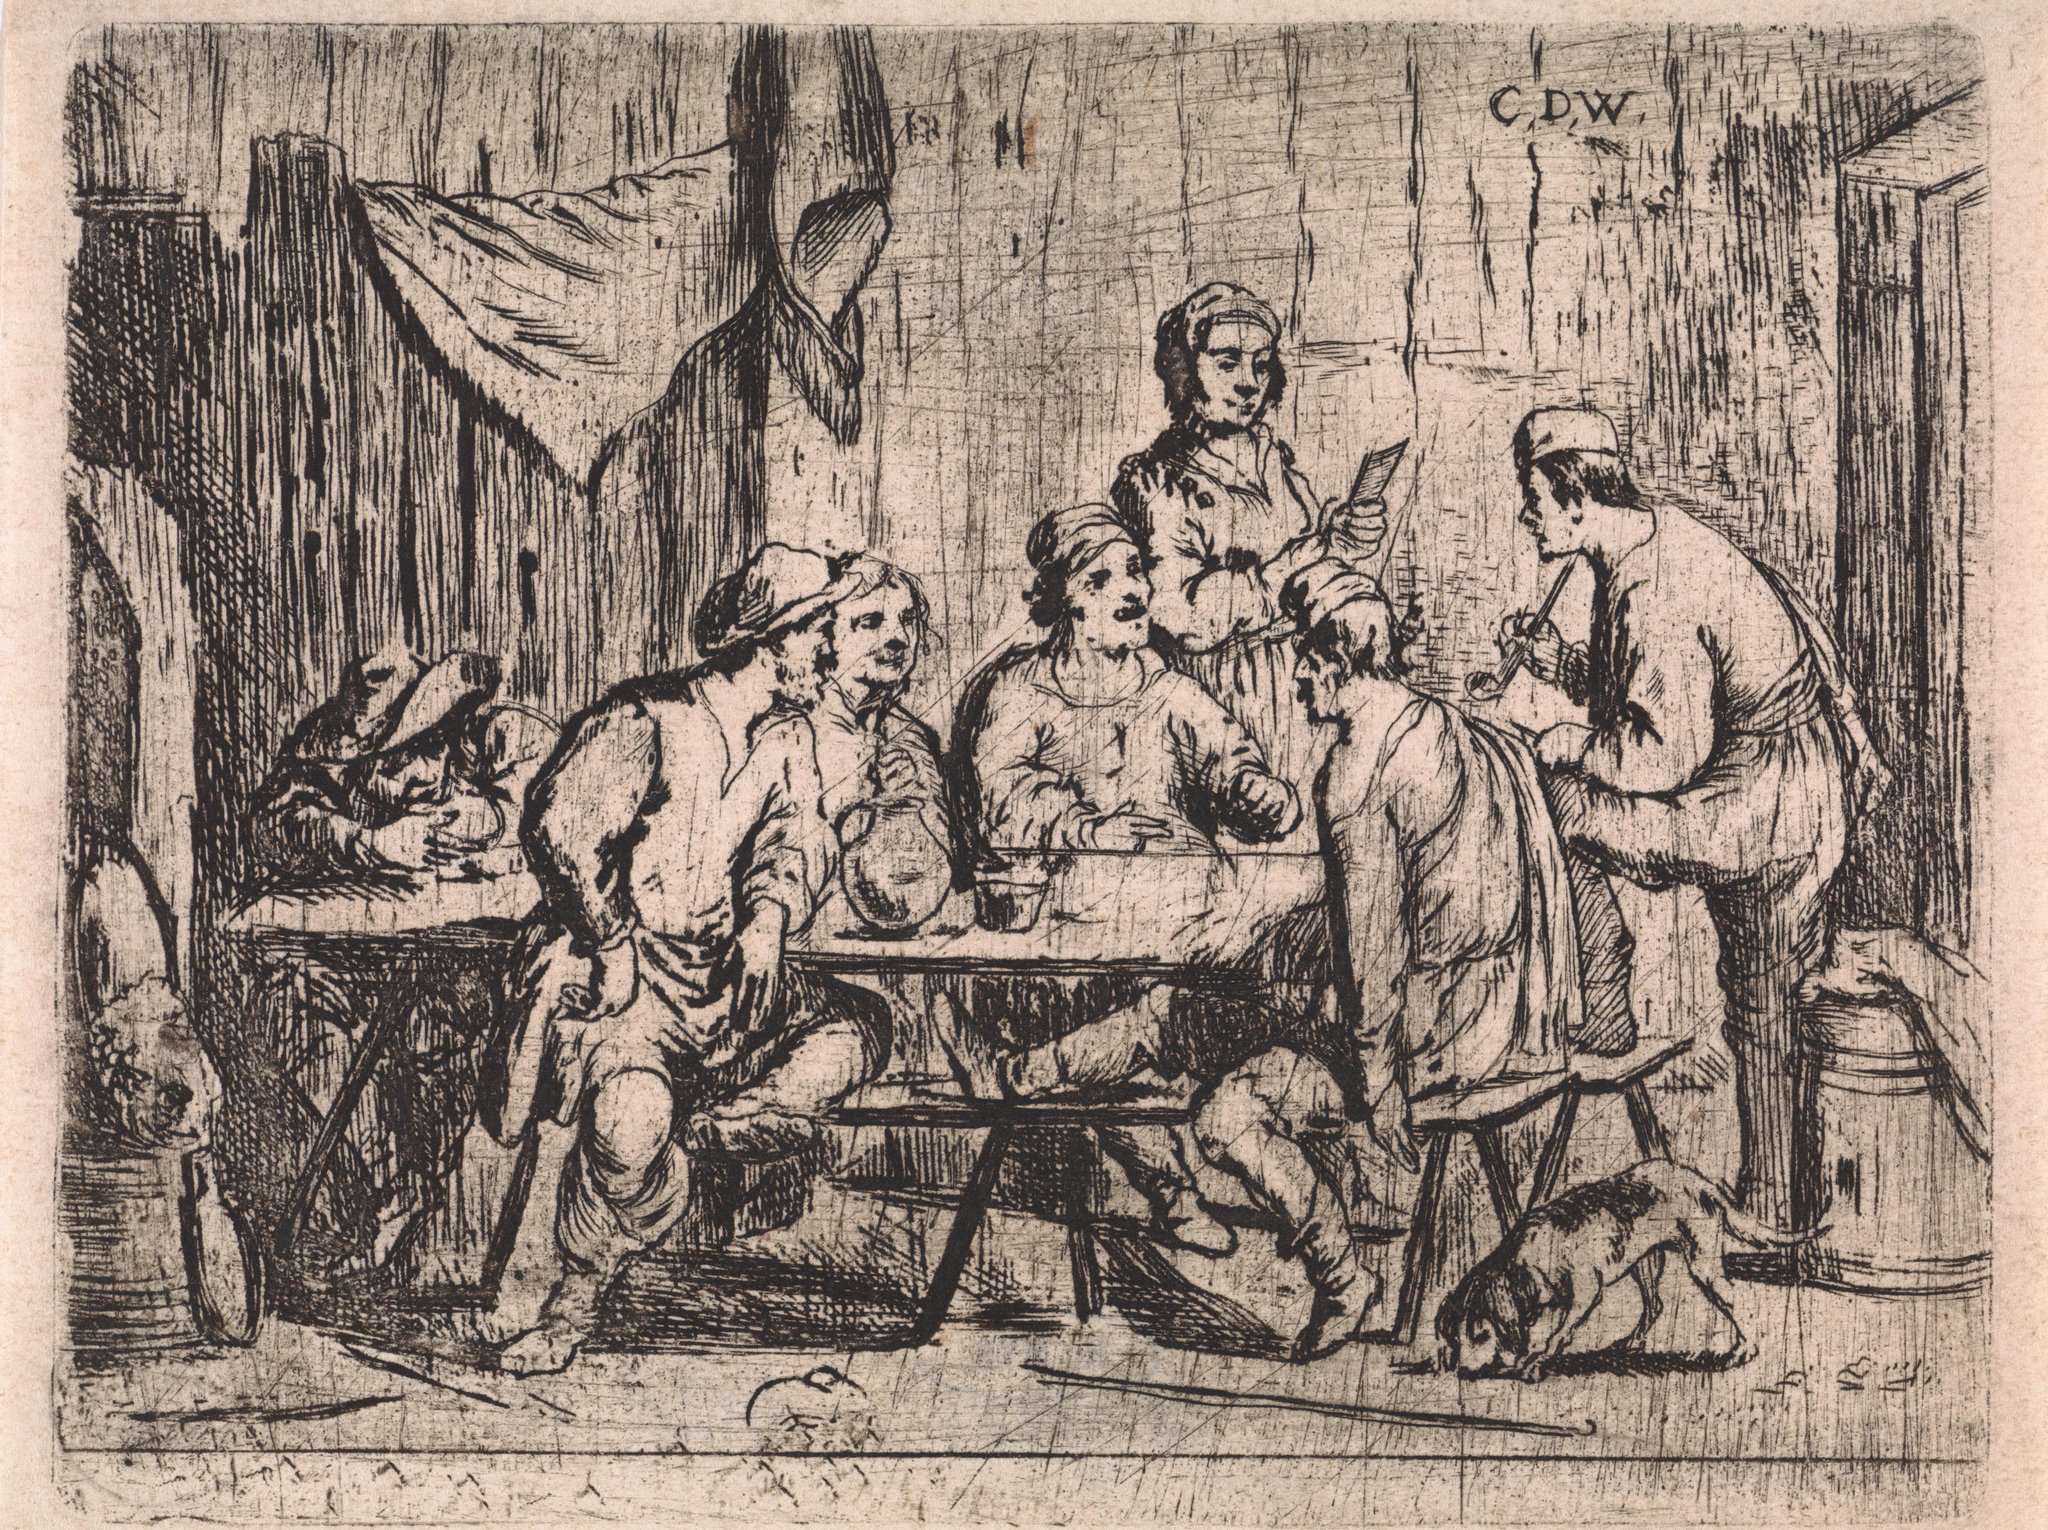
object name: print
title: Genretaferelen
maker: cornelis de wael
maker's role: draughtsman, print maker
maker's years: 1592-1667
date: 1630-1648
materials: paper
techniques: etching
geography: italy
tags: inn, coffee-house, public house, etc., pipe ~ tobacco, dog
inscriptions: collector's mark: Lugt 514, collector's mark: Lugt 2228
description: Interieur van een herberg met boeren die in gesprek zijn. Eén van hen rookt een pijp. Achter de tafel staat een de herbergierster met een rekening in de hand. Rechts op de voorgrond een hond.